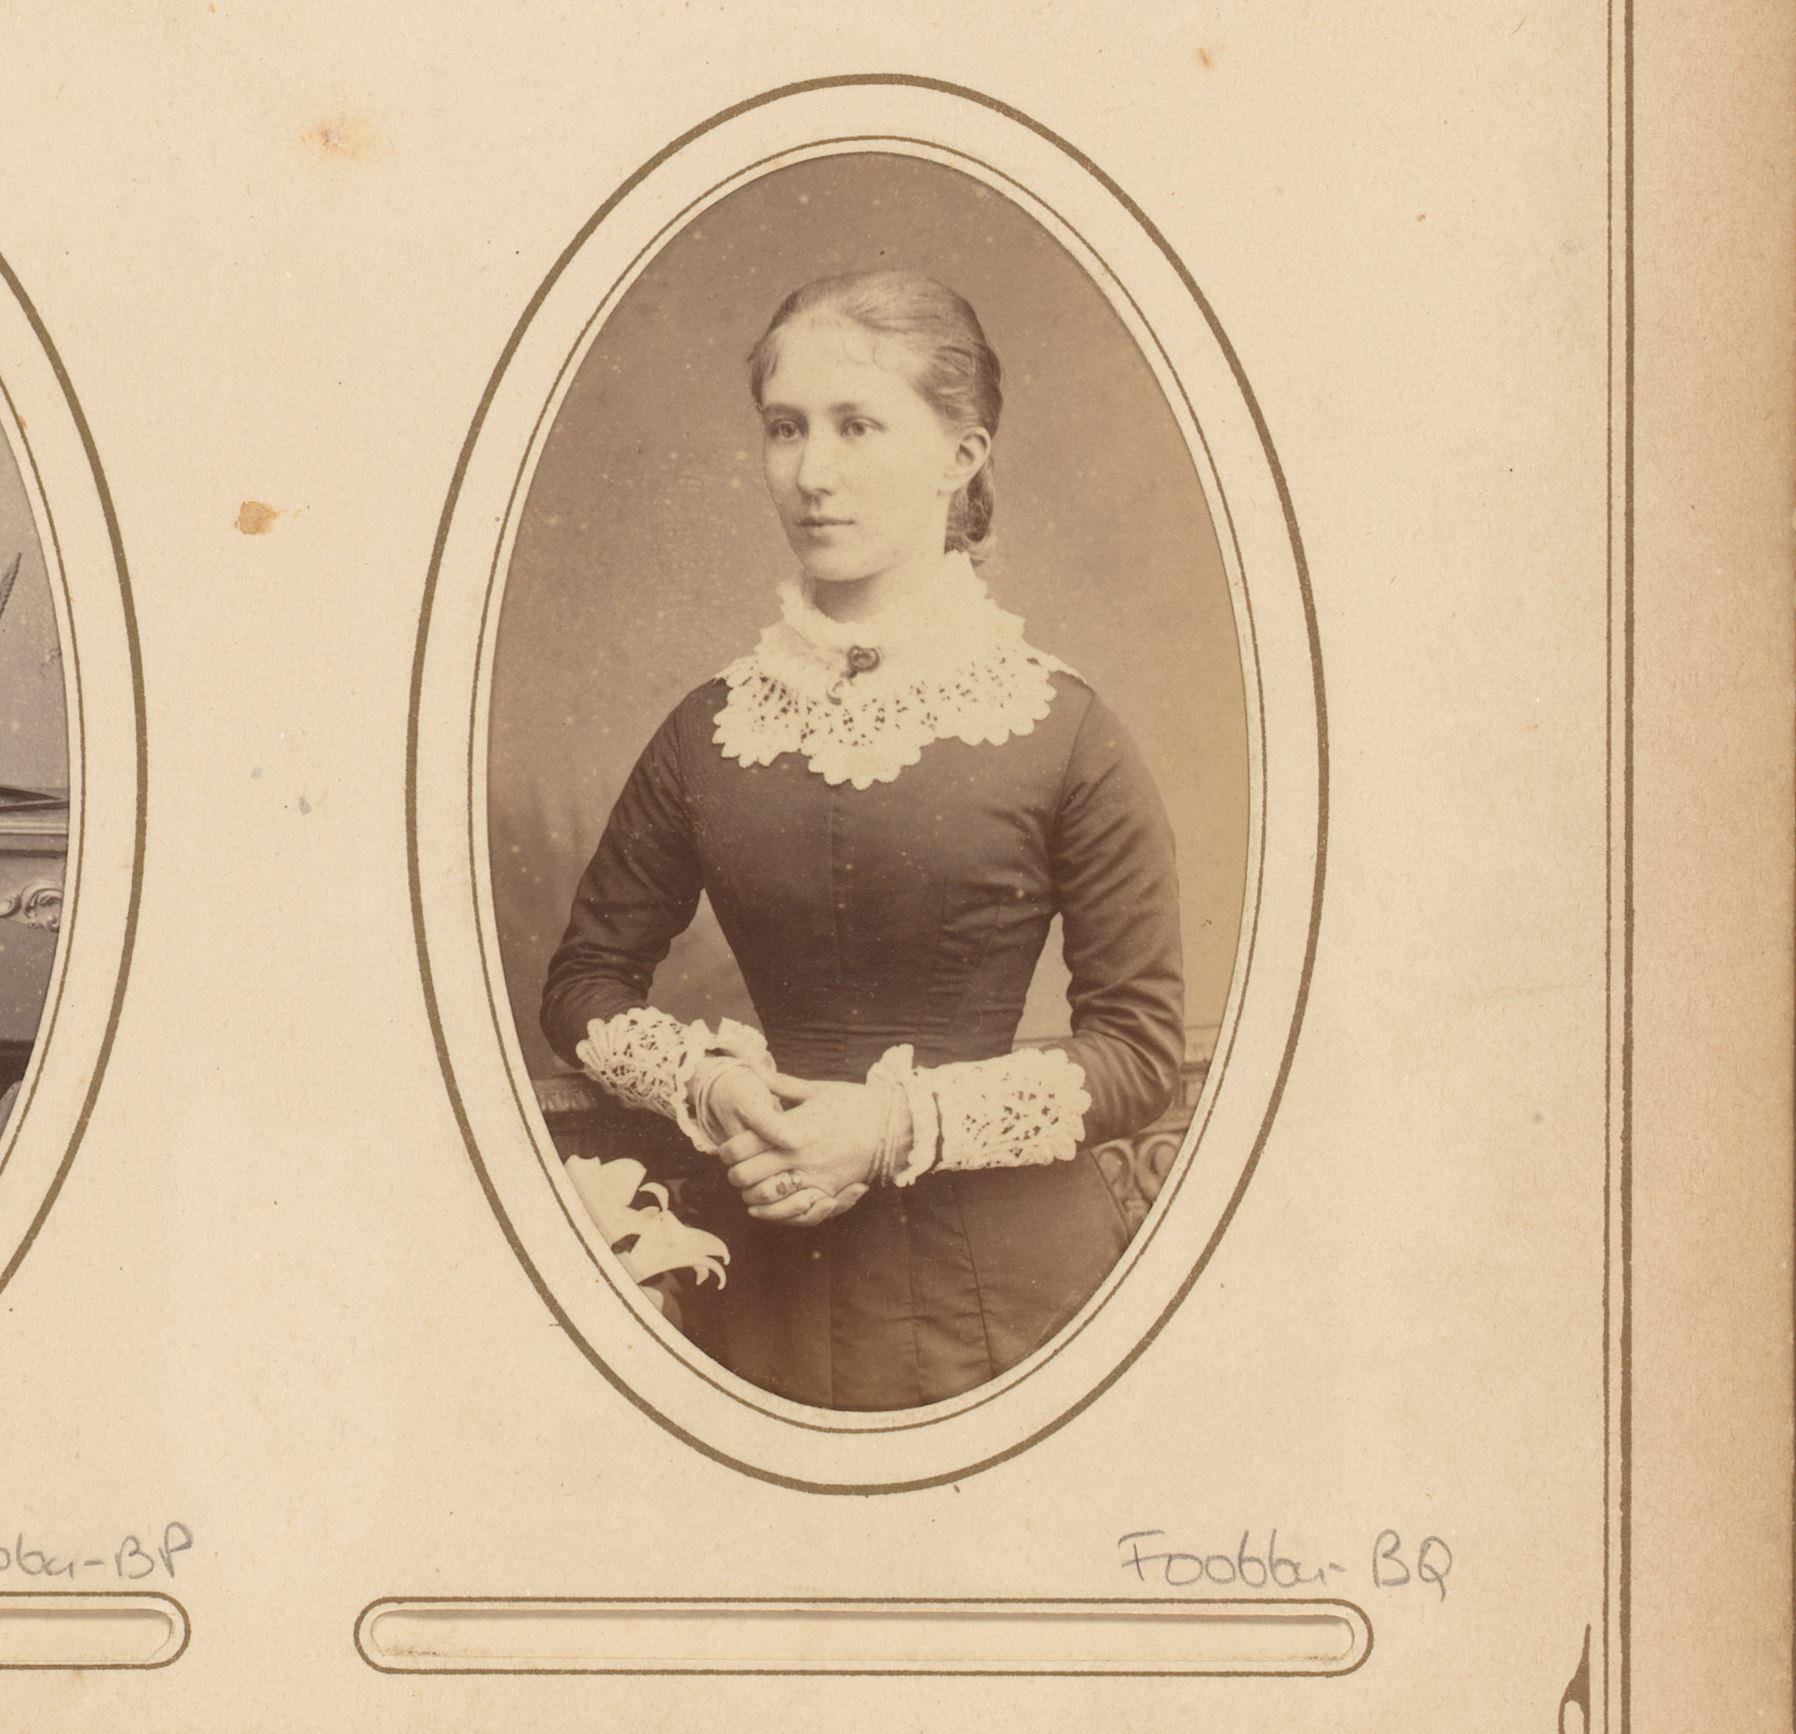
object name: album leaf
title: Portret van een jonge vrouw bij een witte lelie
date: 1808-1879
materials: cardboard, photographic support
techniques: albumen print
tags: historical persons - bb - woman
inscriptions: annotation: ‘Amy [...] 1879’, inscription: ‘W&D Downey (...) 9, Eldon Square/ Newcastle on Tyne/ London Studio 57 & Ebury St. Eaton Square’, number: ‘9901’